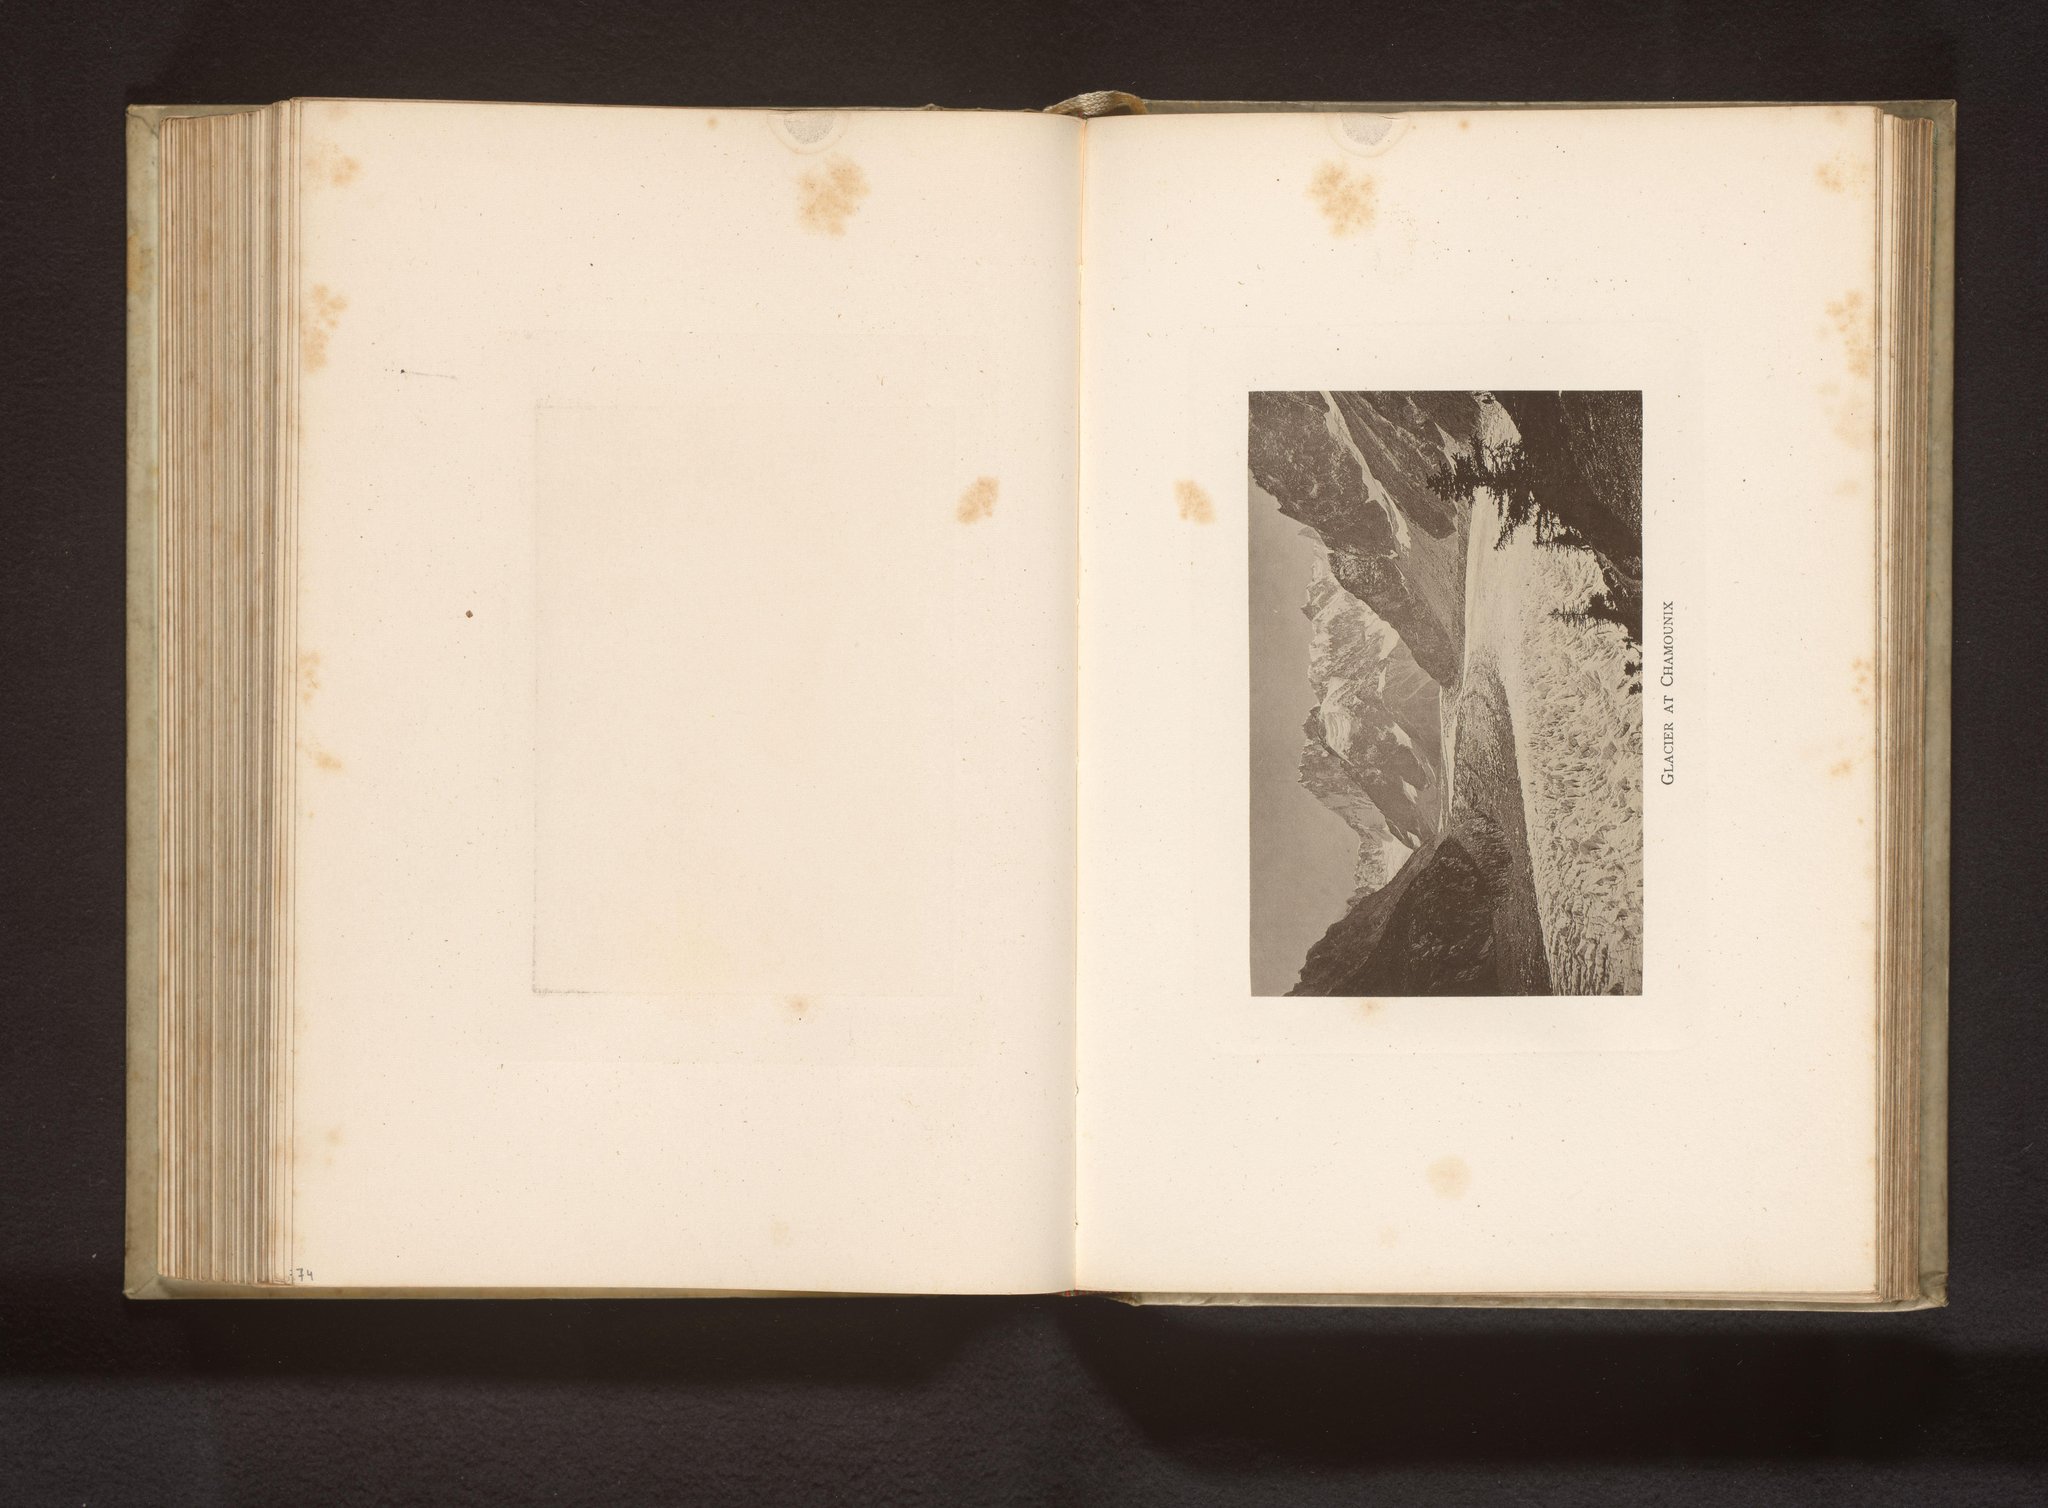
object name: photomechanical print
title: Glacier ar Chamounix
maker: Anonymous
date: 1874-1884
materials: paper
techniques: photograph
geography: chamonix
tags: glacier